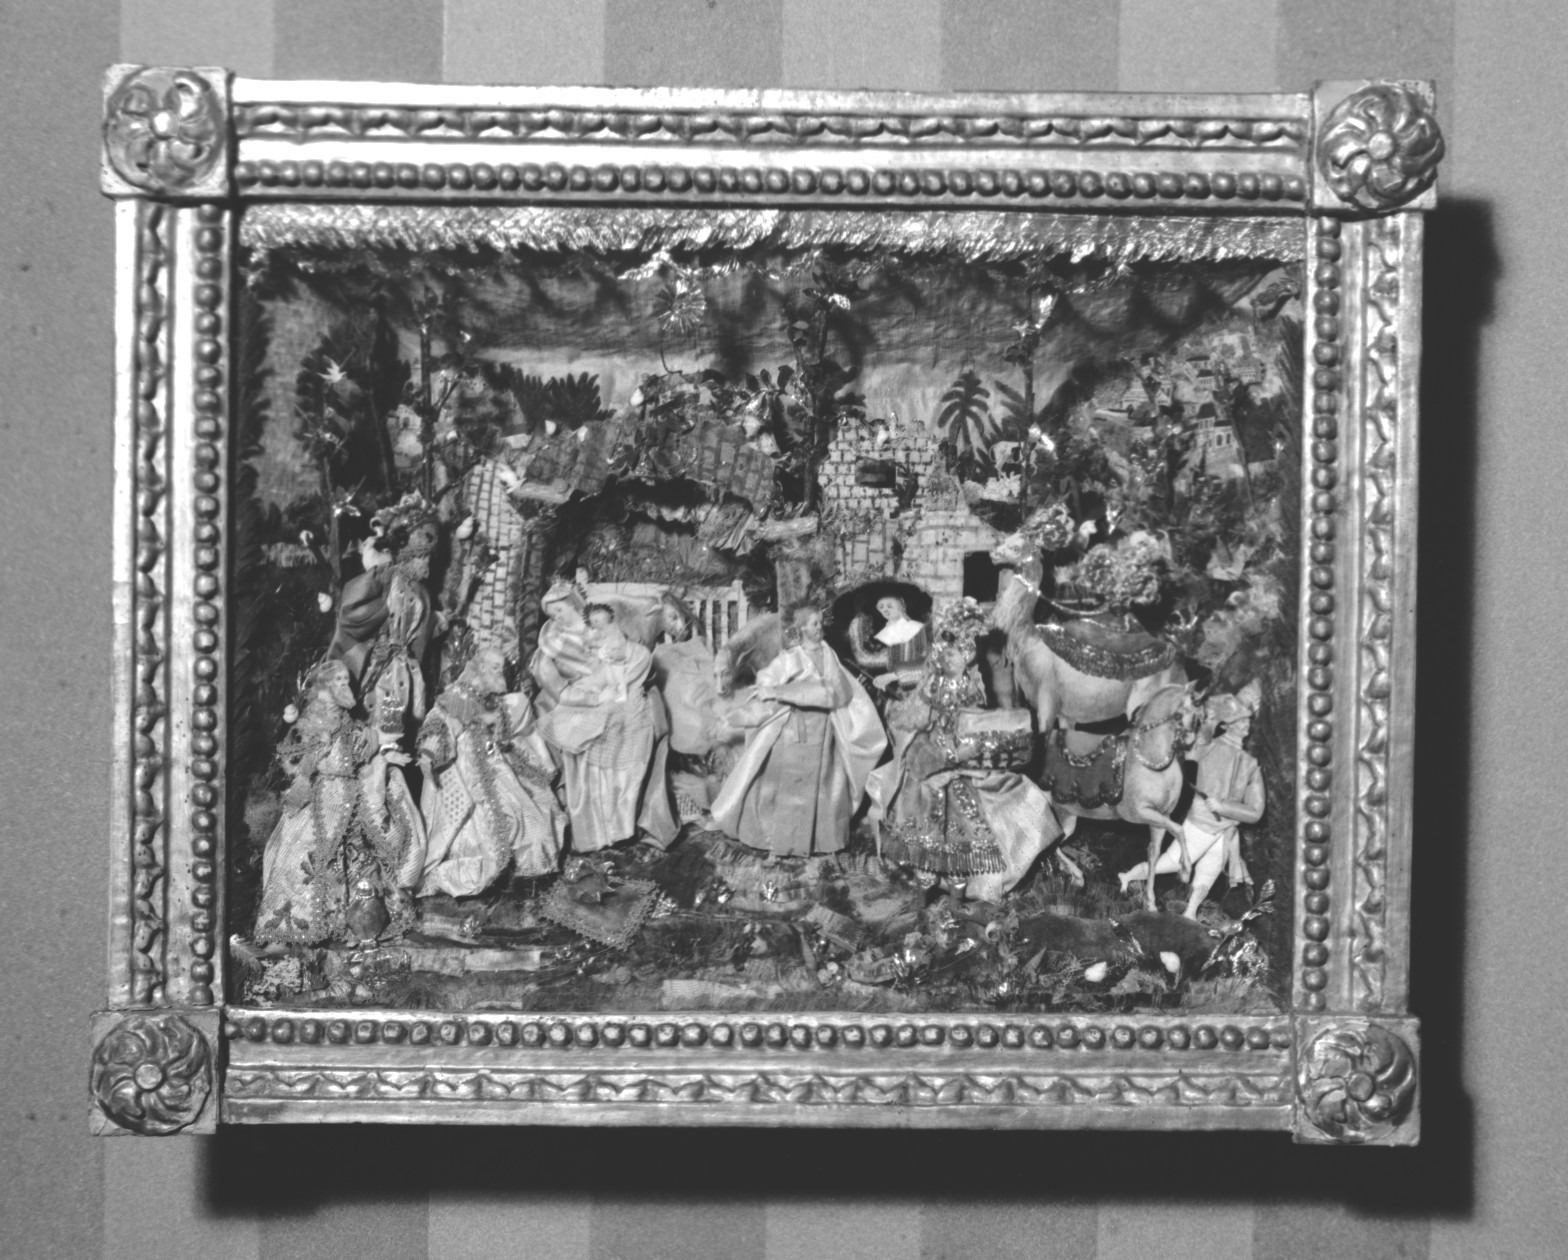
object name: christmas crib in box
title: Adoration of the Magi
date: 1801-1900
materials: foil, glass, paper, tin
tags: adoration of the magi